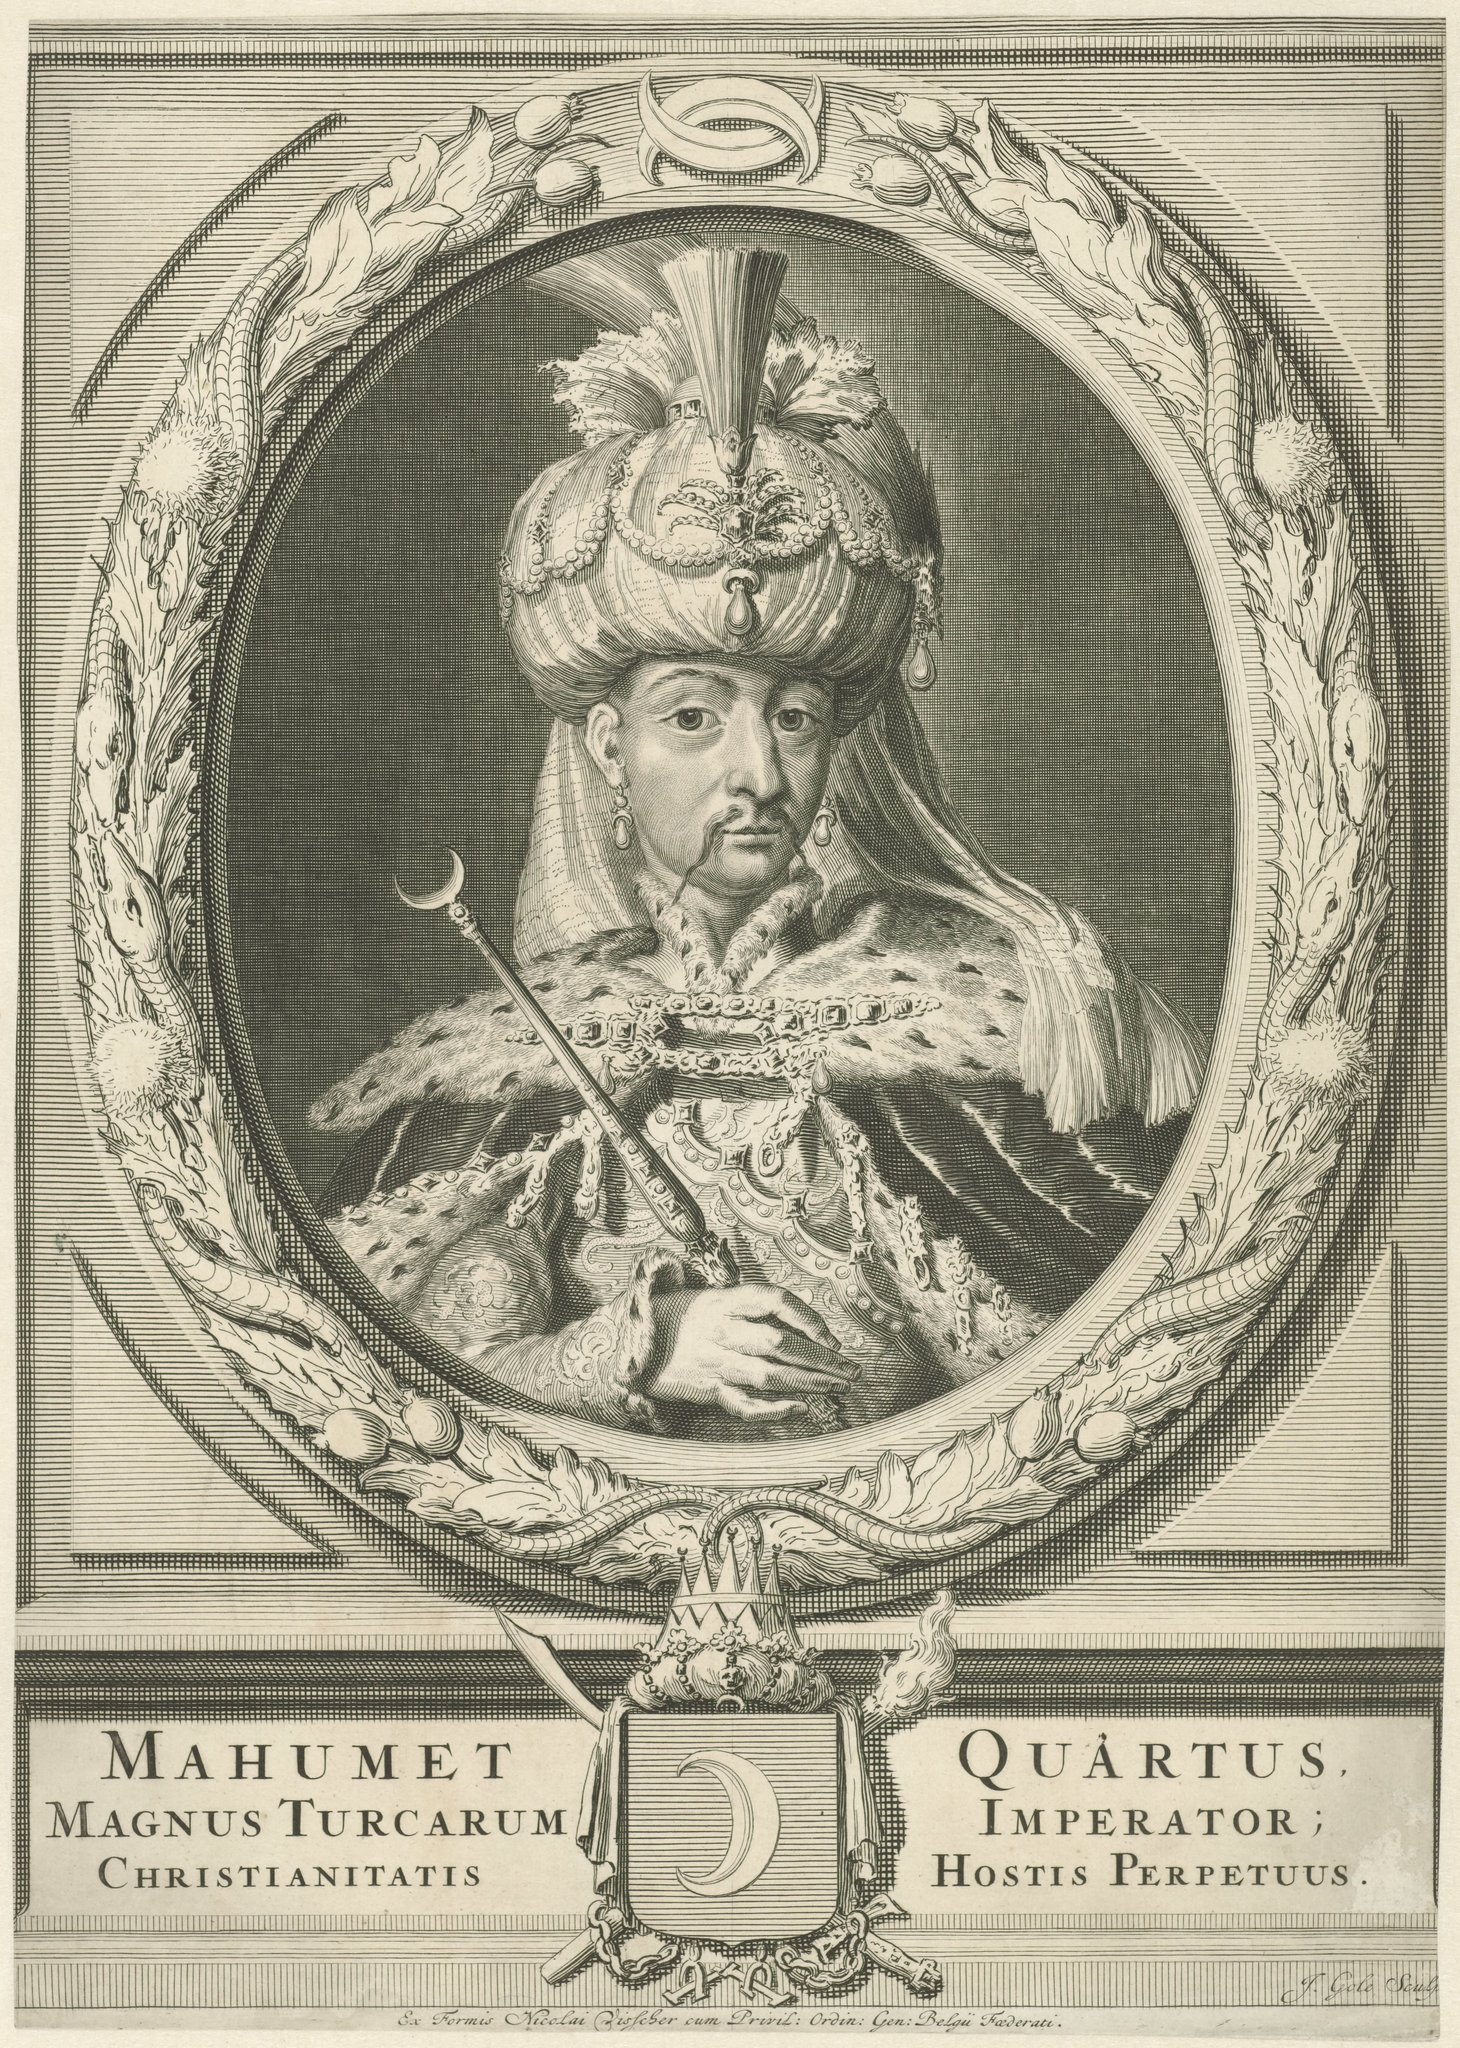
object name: print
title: Portret van Mehmet IV, sultan van het Ottomaanse Rijk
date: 1670-1724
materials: paper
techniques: engraving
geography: amsterdam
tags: sultan, mehmet iv (sultan van het ottomaanse rijk)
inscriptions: collector's mark: Lugt 2228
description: Portret in ornamentele, ovale lijst van sultan Mehmet IV. Ten halven lijve naar rechts. Onder het portret het wapenschild van het Ottomaanse Rijk. De prent heeft een Latijns onderschrift.